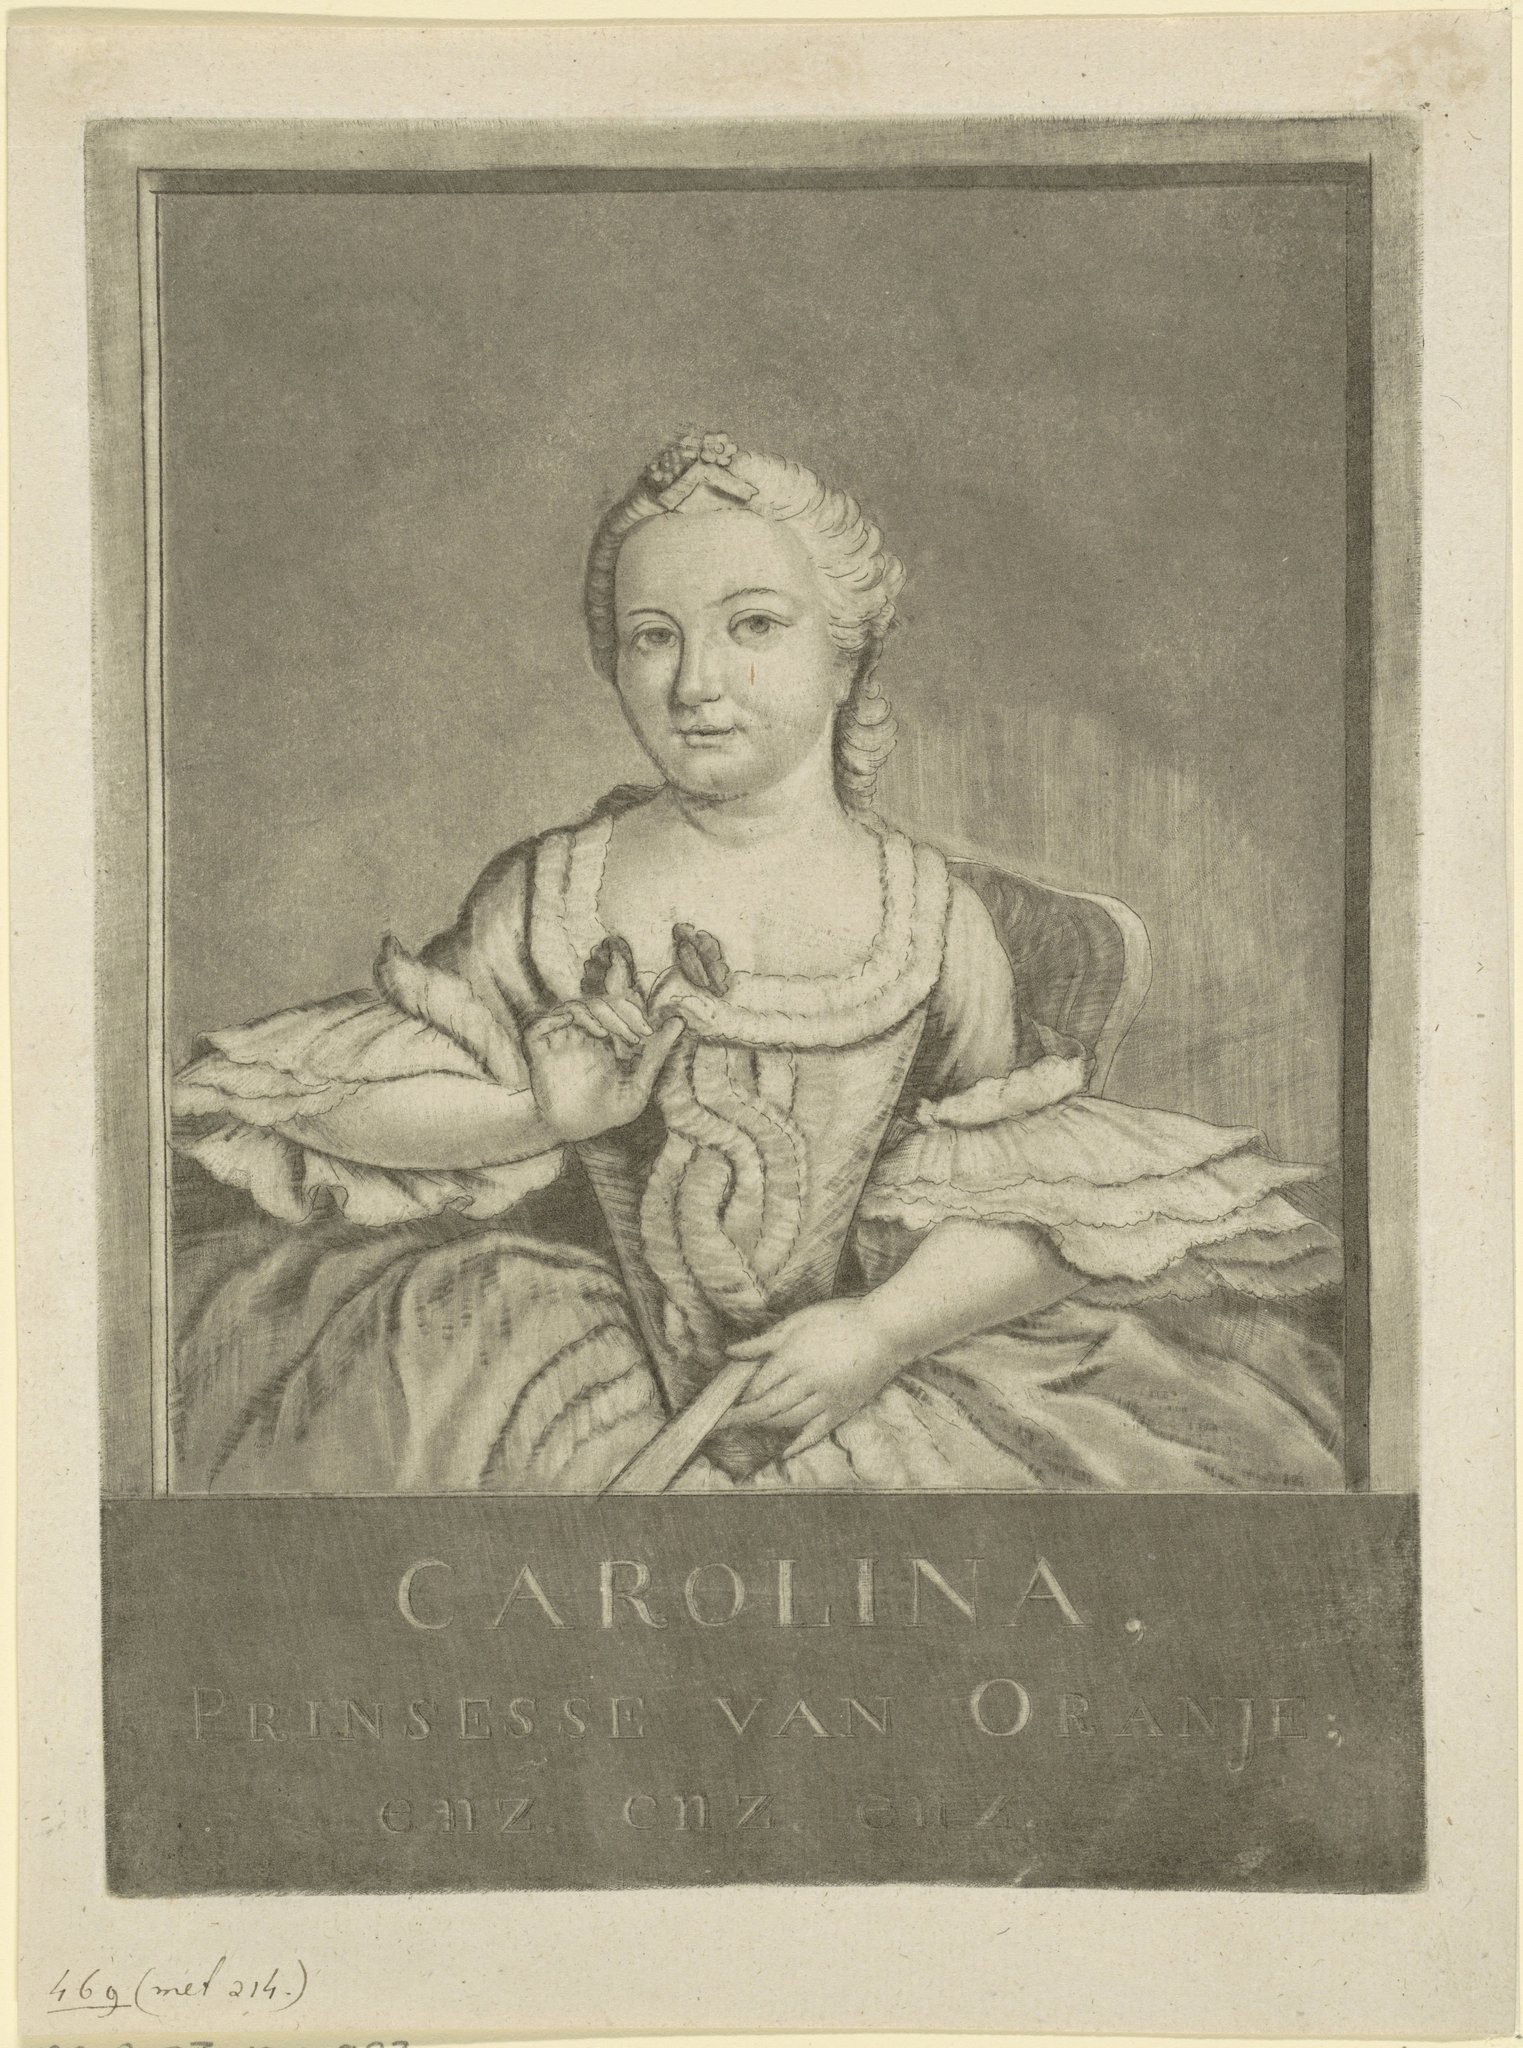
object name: print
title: Portret van Carolina, prinses van Oranje-Nassau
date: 1770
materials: paper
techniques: etching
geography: leeuwarden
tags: carolina (prinses van oranje-nassau)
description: De hier vermelde titel verwijst naar de hoogst verkregen titel van de geportretteerde, niet per se naar de titel die de geportretteerde op deze voorstelling draagt. Prent uit: Bosch, Johannes van den. De heeren stadhouderen van Vriesland, zedert den jare acht-hondert, volgens hoogst derzelver successie kortelyk beschreven. Leeuwarden: Abraham Ferwerda en Gerrit Tresling, 1770.